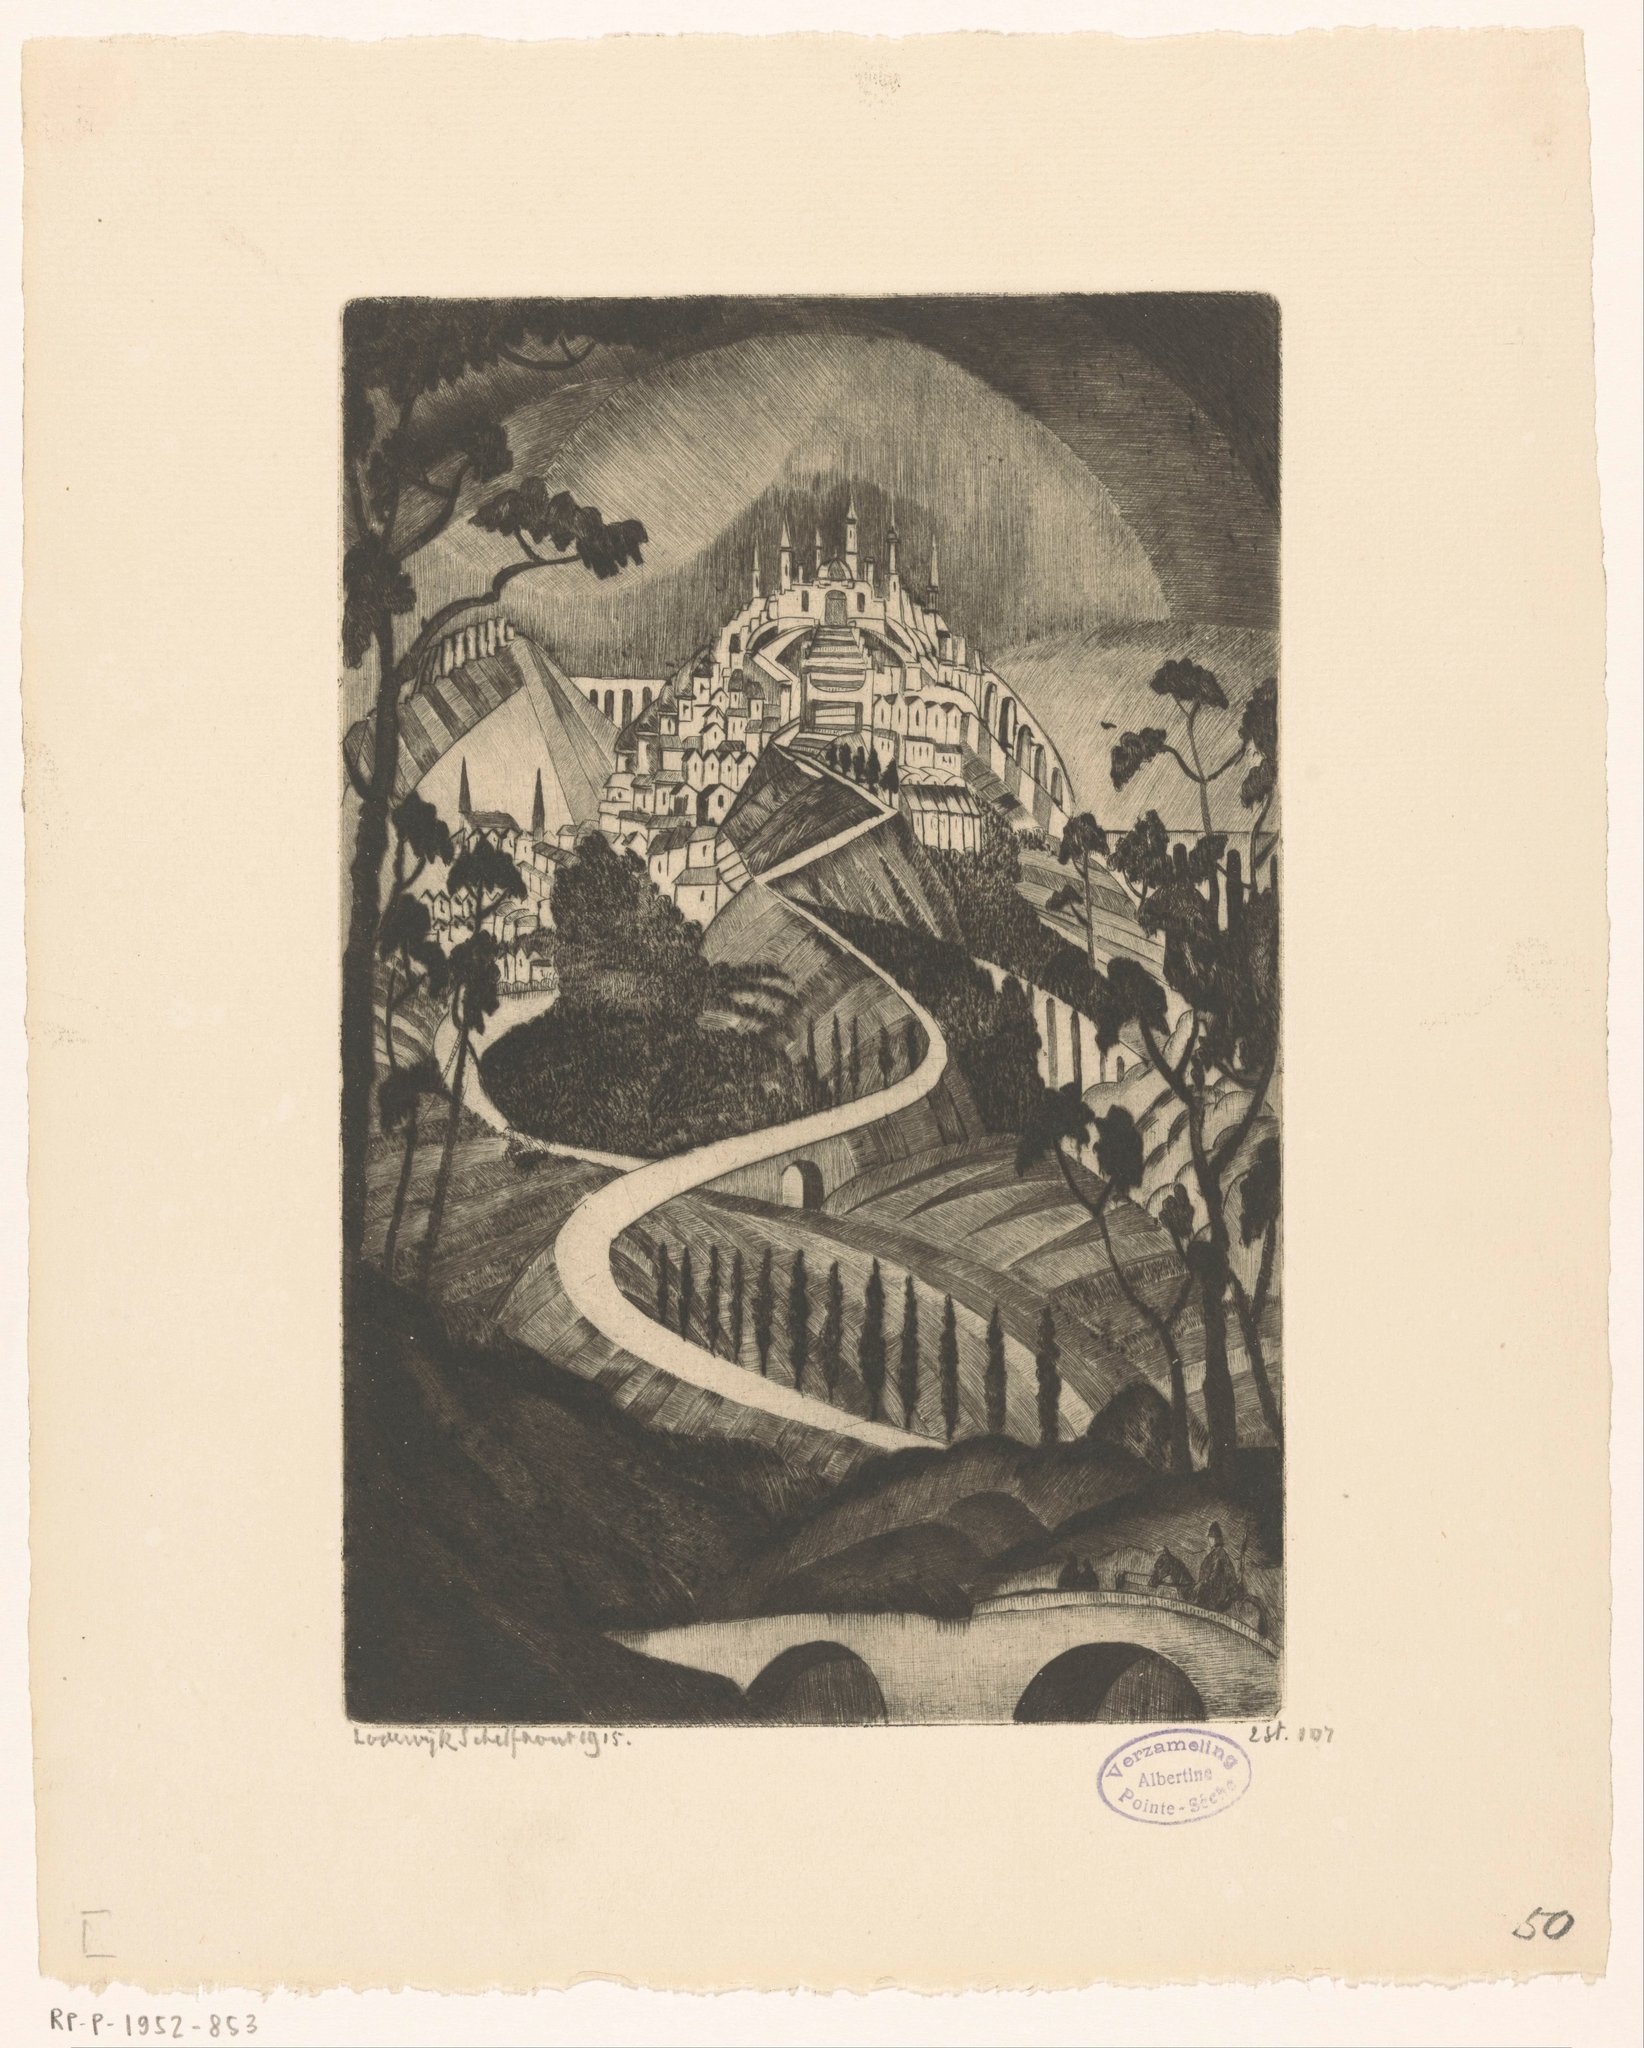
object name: print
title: Berg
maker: lodewijk schelfhout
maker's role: draughtsman, print maker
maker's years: 1881-1943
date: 1915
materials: paper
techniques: drypoint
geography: netherlands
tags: prospect of village, silhouette of village, road, path, mountains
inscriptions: collector's mark: Lugt 2228, collector's mark: Lugt 5i, collector's mark: Lugt 2760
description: Huizen en een gebouw met torens op een berg. Op de voorgrond een weg die naar de berg toe kronkelt.